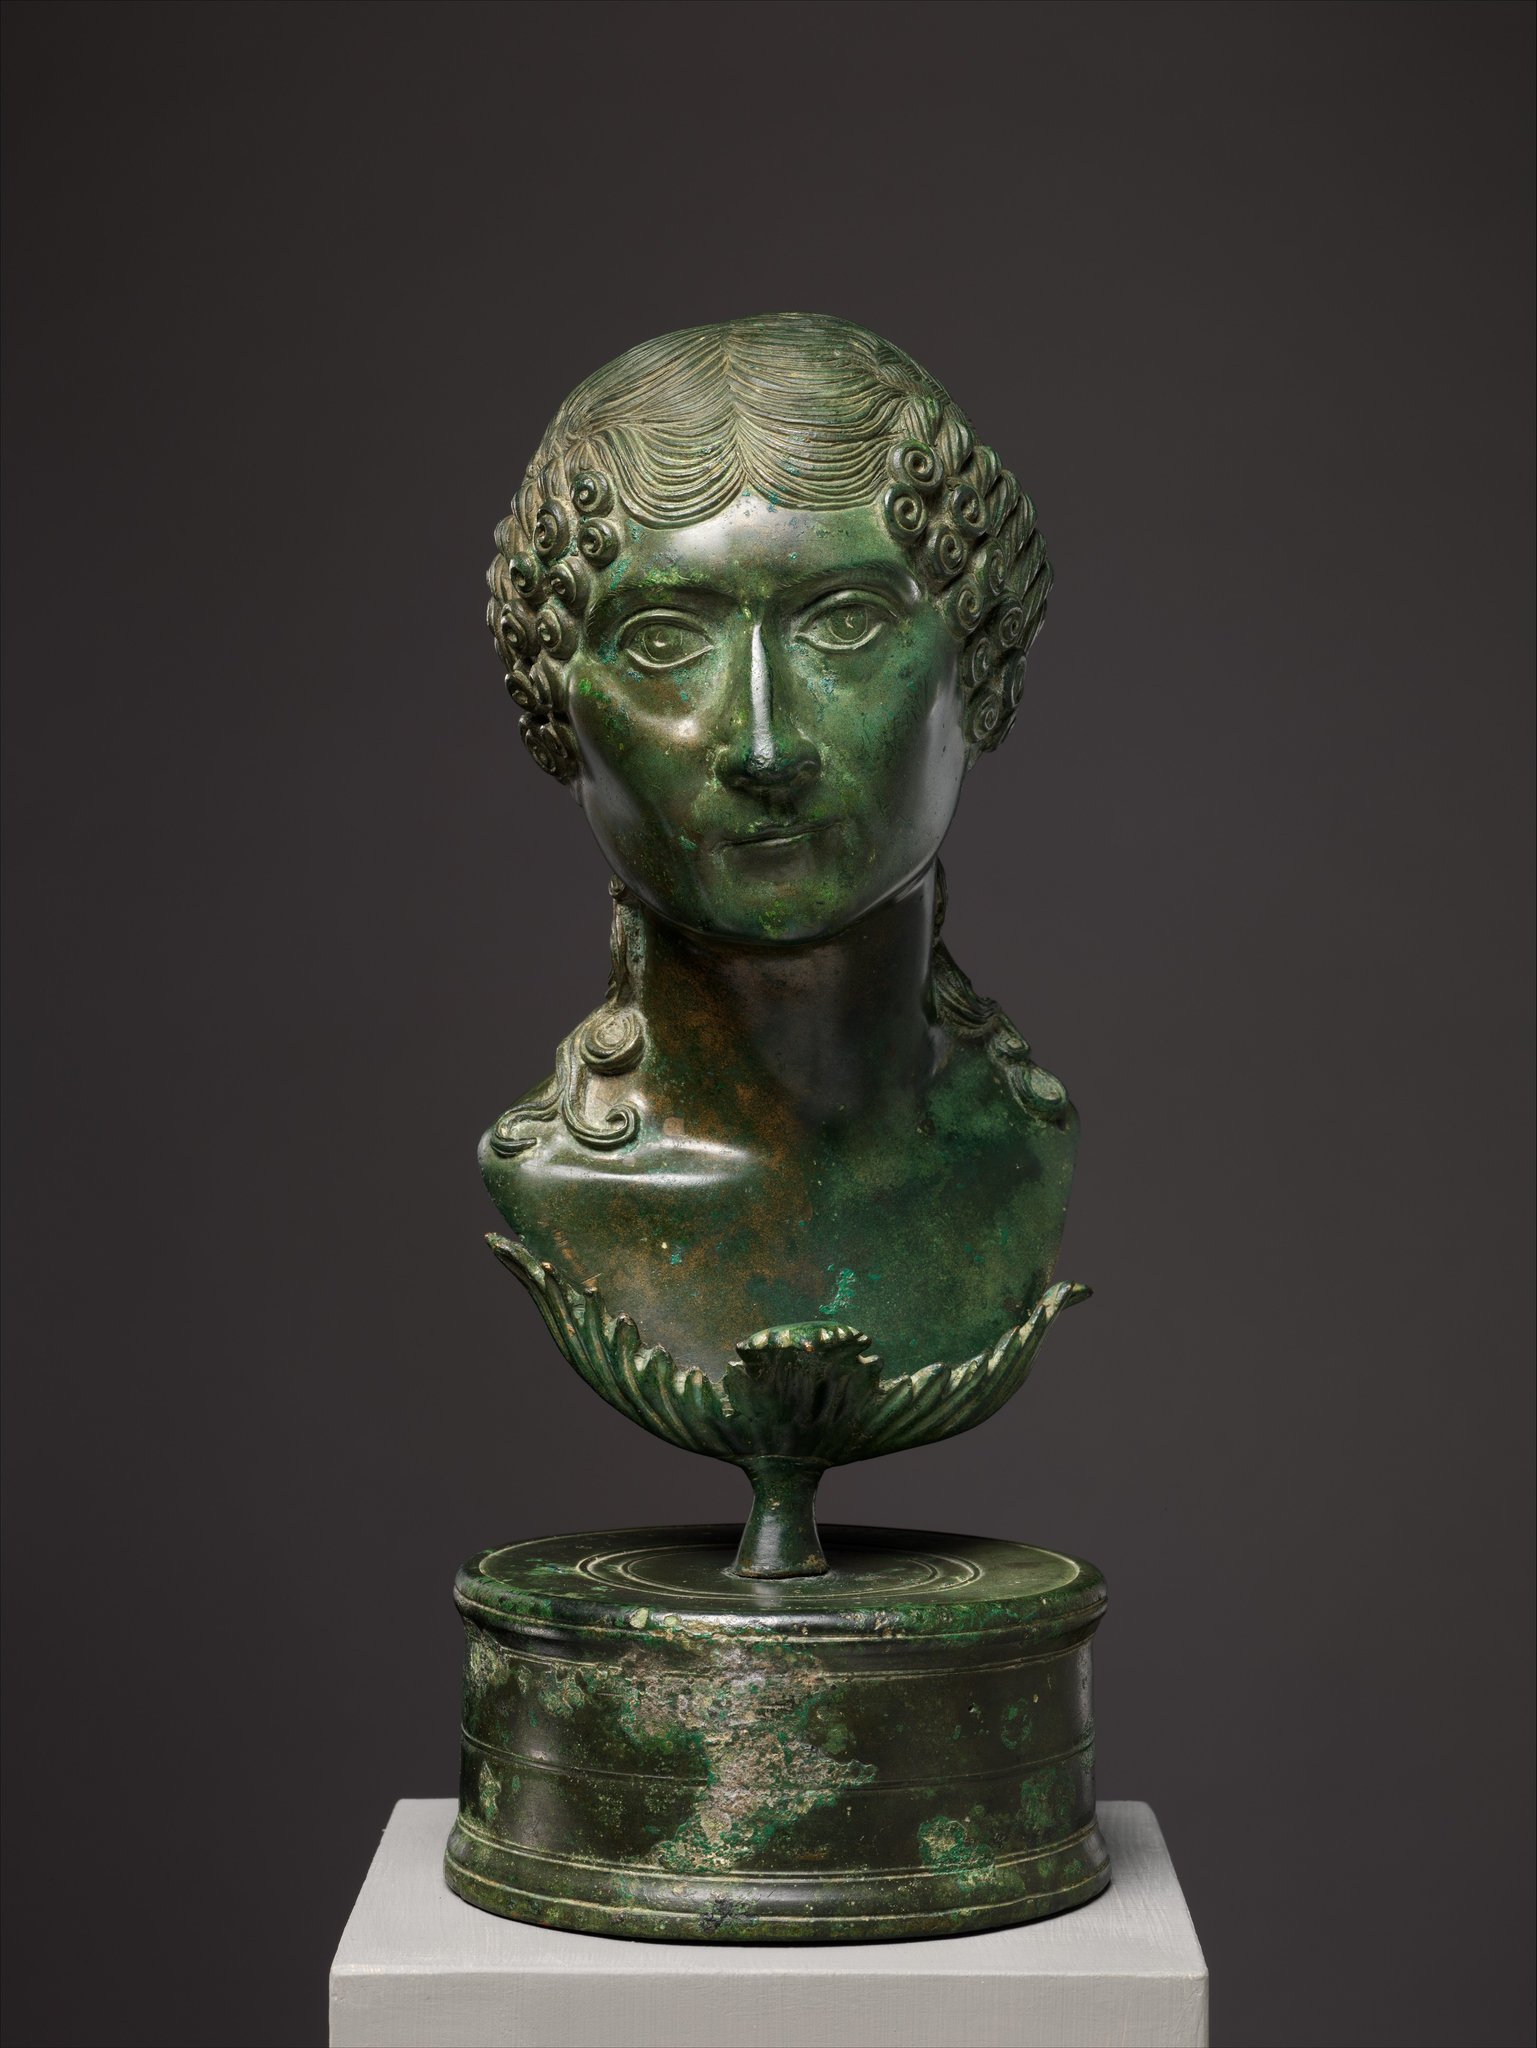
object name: portrait bust resembling agrippina the elder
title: Bronze portrait bust of a Roman matron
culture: roman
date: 20-50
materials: bronze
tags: portraits,women